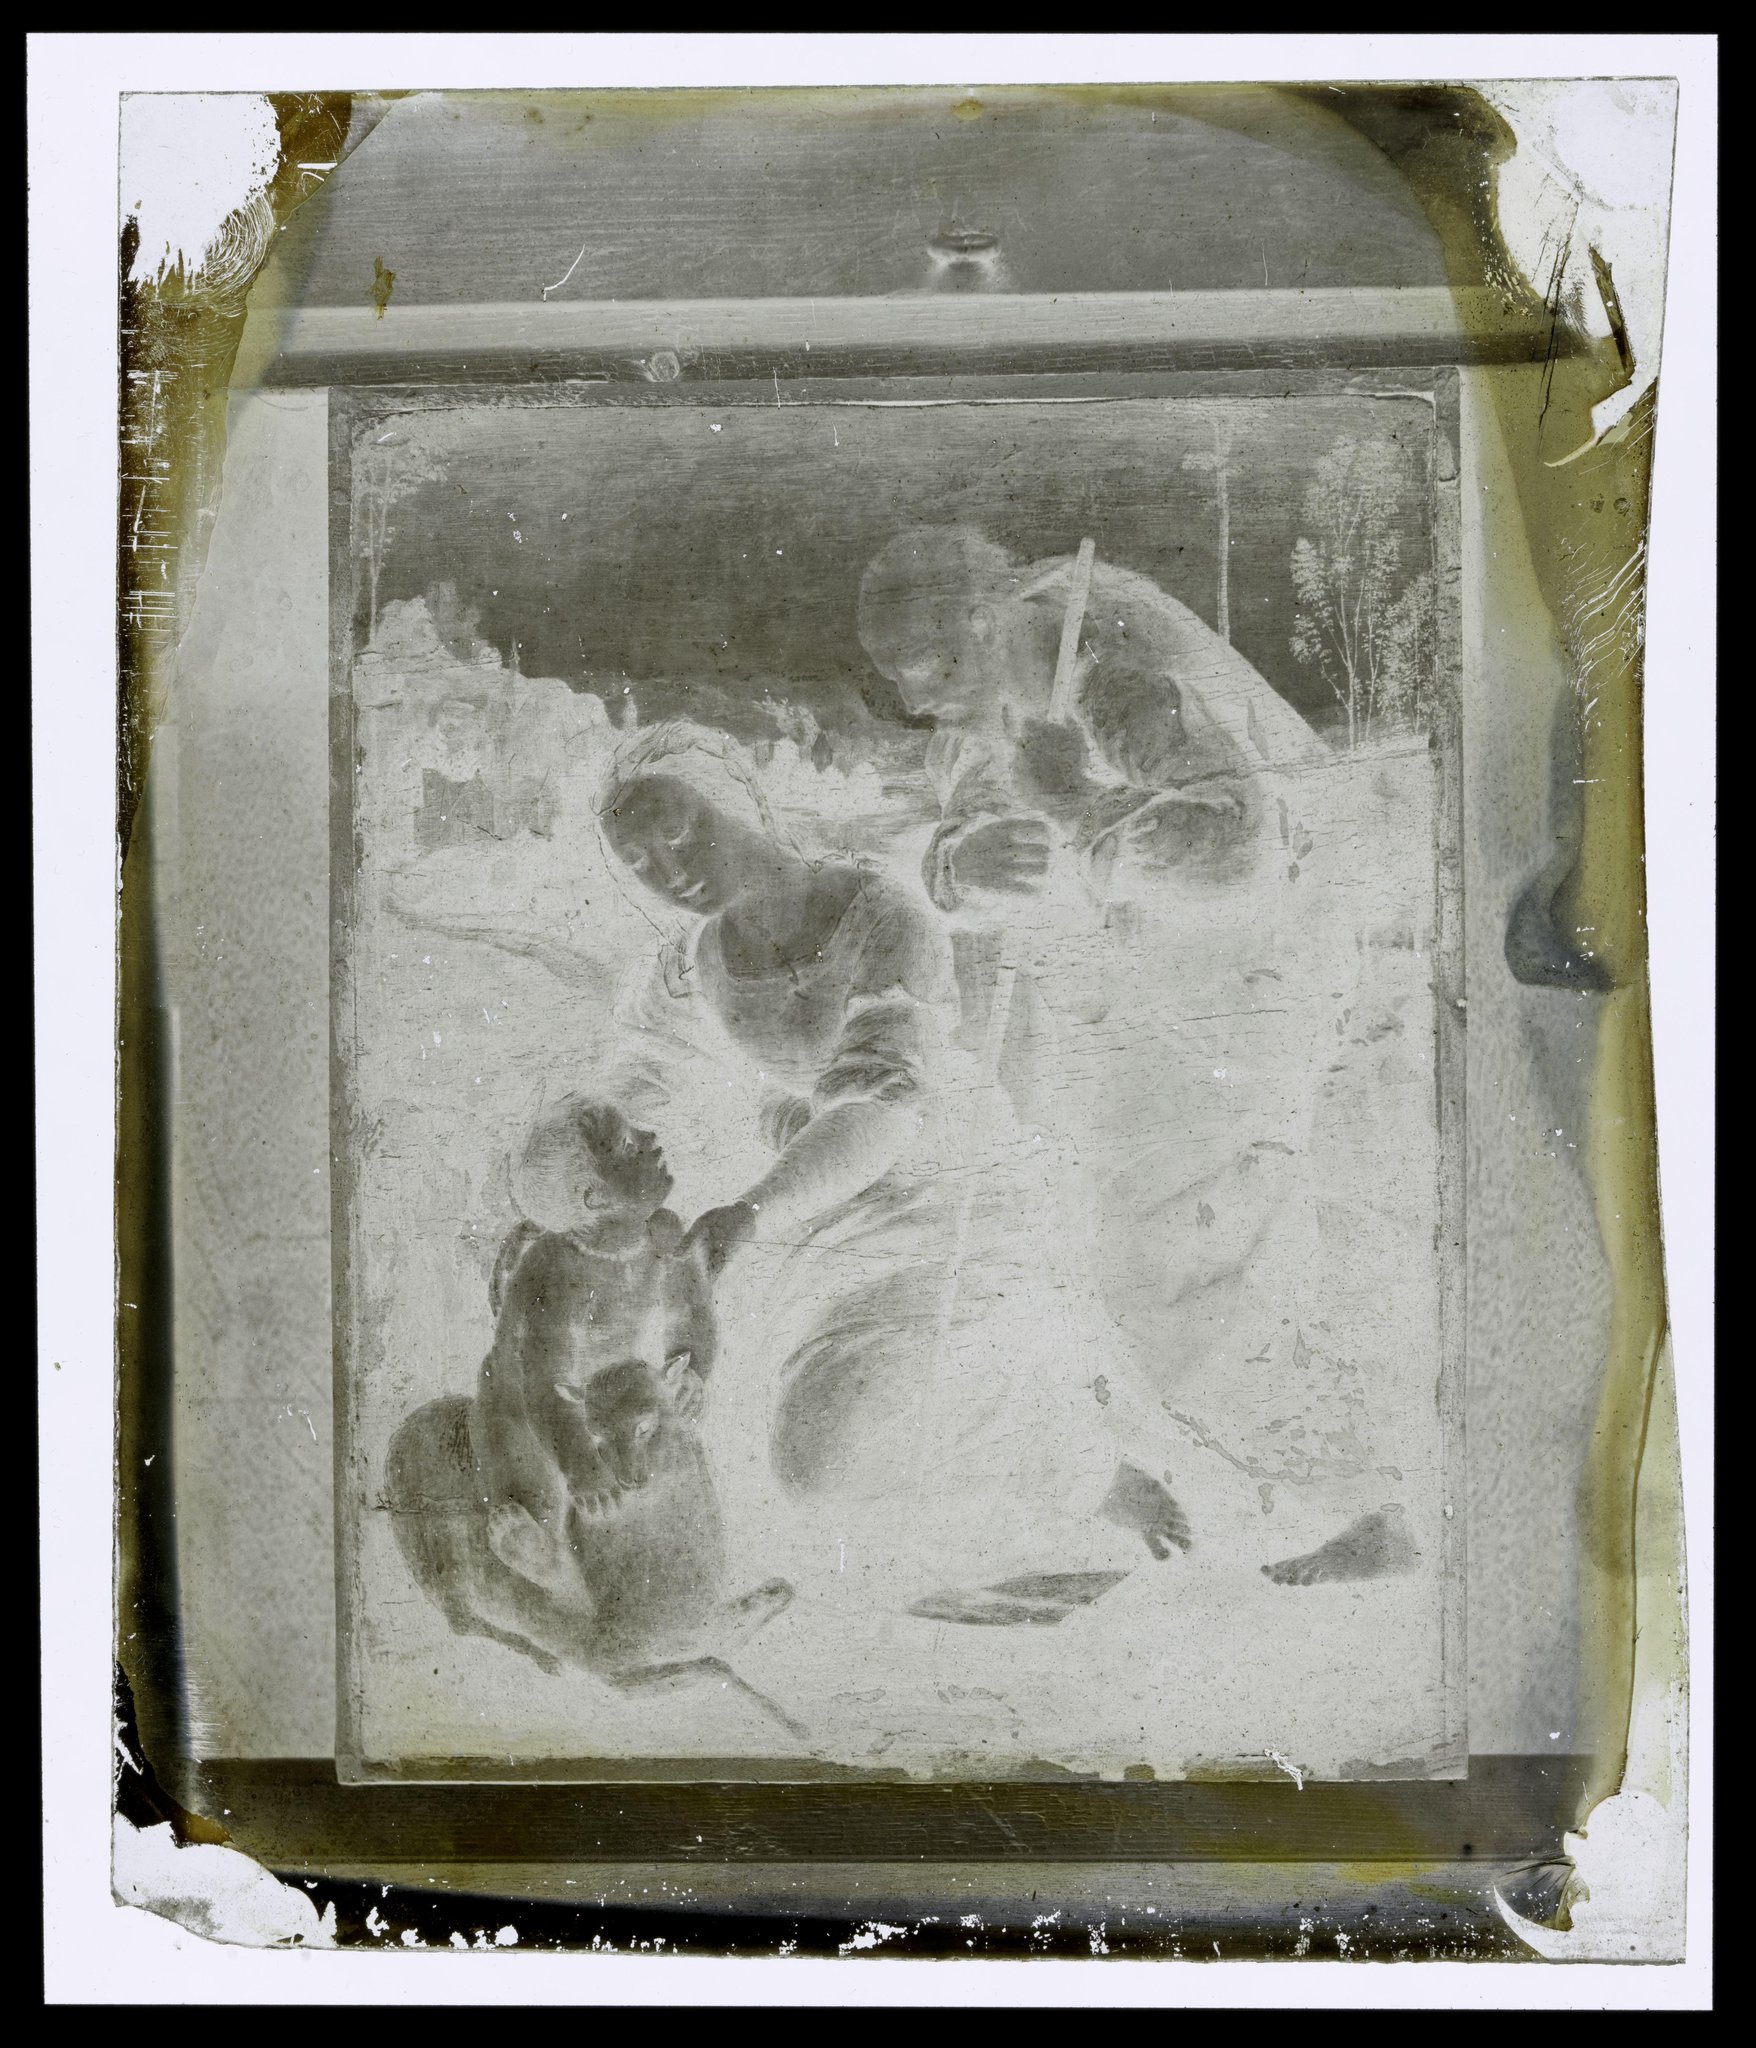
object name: reproduction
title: Fotoreproductie van een schilderij van de Heilige familie met een lam, door Rafaël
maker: laurens lodewijk kleijn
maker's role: draughtsman, painter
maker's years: 1826-1909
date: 1865-1900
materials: glass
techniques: collodion process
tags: holy family (alone), 'trinitas terrestris'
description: Onderdeel van een groep glasnegatieven uit de nalatenschap van de schilder Laurens Lodewijk Kleijn, met stillevens, portretten, zelfportretten en kunstreproducties.